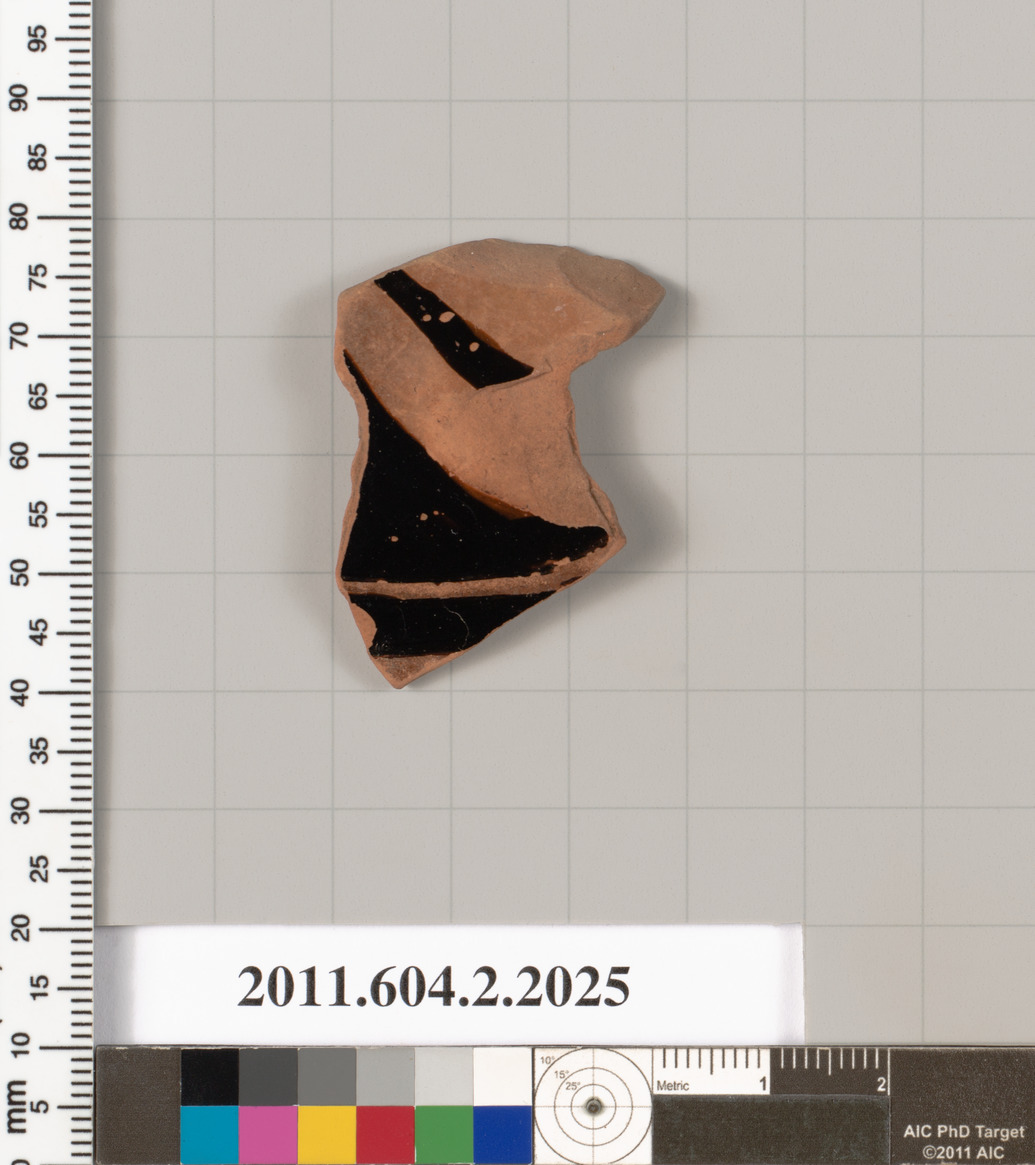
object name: askos fragment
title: Terracotta fragment of an askos (flask with a spout and handle over the top)?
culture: greek, attic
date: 425-401 BCE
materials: terracotta